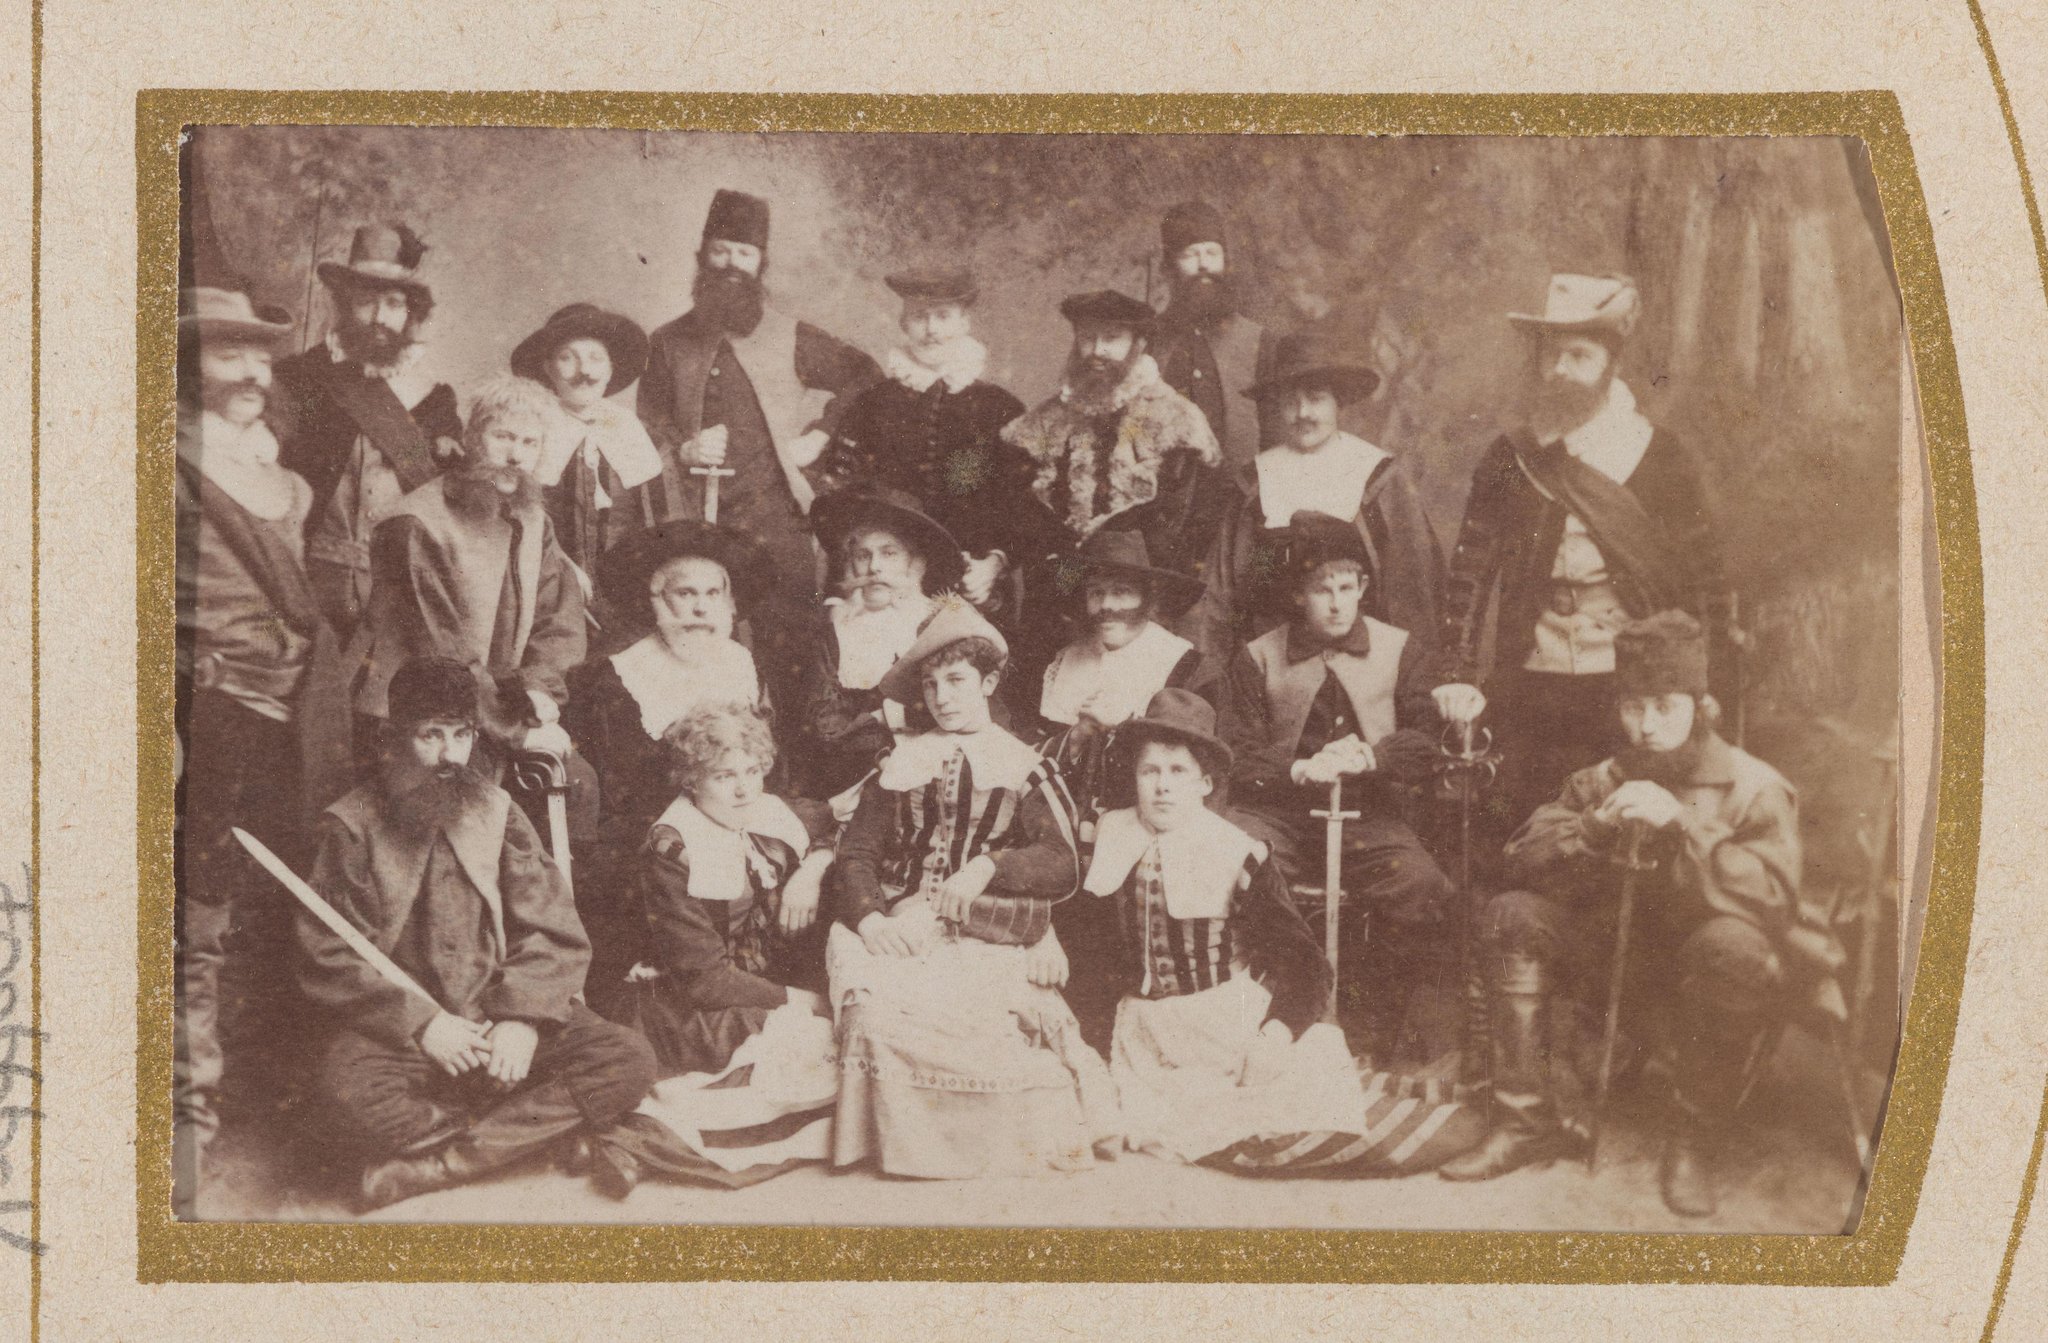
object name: carte de visite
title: Groepsportret van studenten in kostuum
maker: jan goedeljee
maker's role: fotograaf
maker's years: 1824-1905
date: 1880-1900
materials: cardboard, photographic support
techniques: albumen print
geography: leiden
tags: historical costume, student, anonymous historical persons portrayed in a group, in a group-portrait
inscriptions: inscription: ‘J. Goedeljee/ Photograaf/ Z. K. H. PRINS ALEXANDER/ der Nederlanden/ PRINS van ORANJE/ en H. K. H./ PRINSES HENDRIK/ der Nederlanden/ Hoogewoerd 160/ nabij de Plantage.’